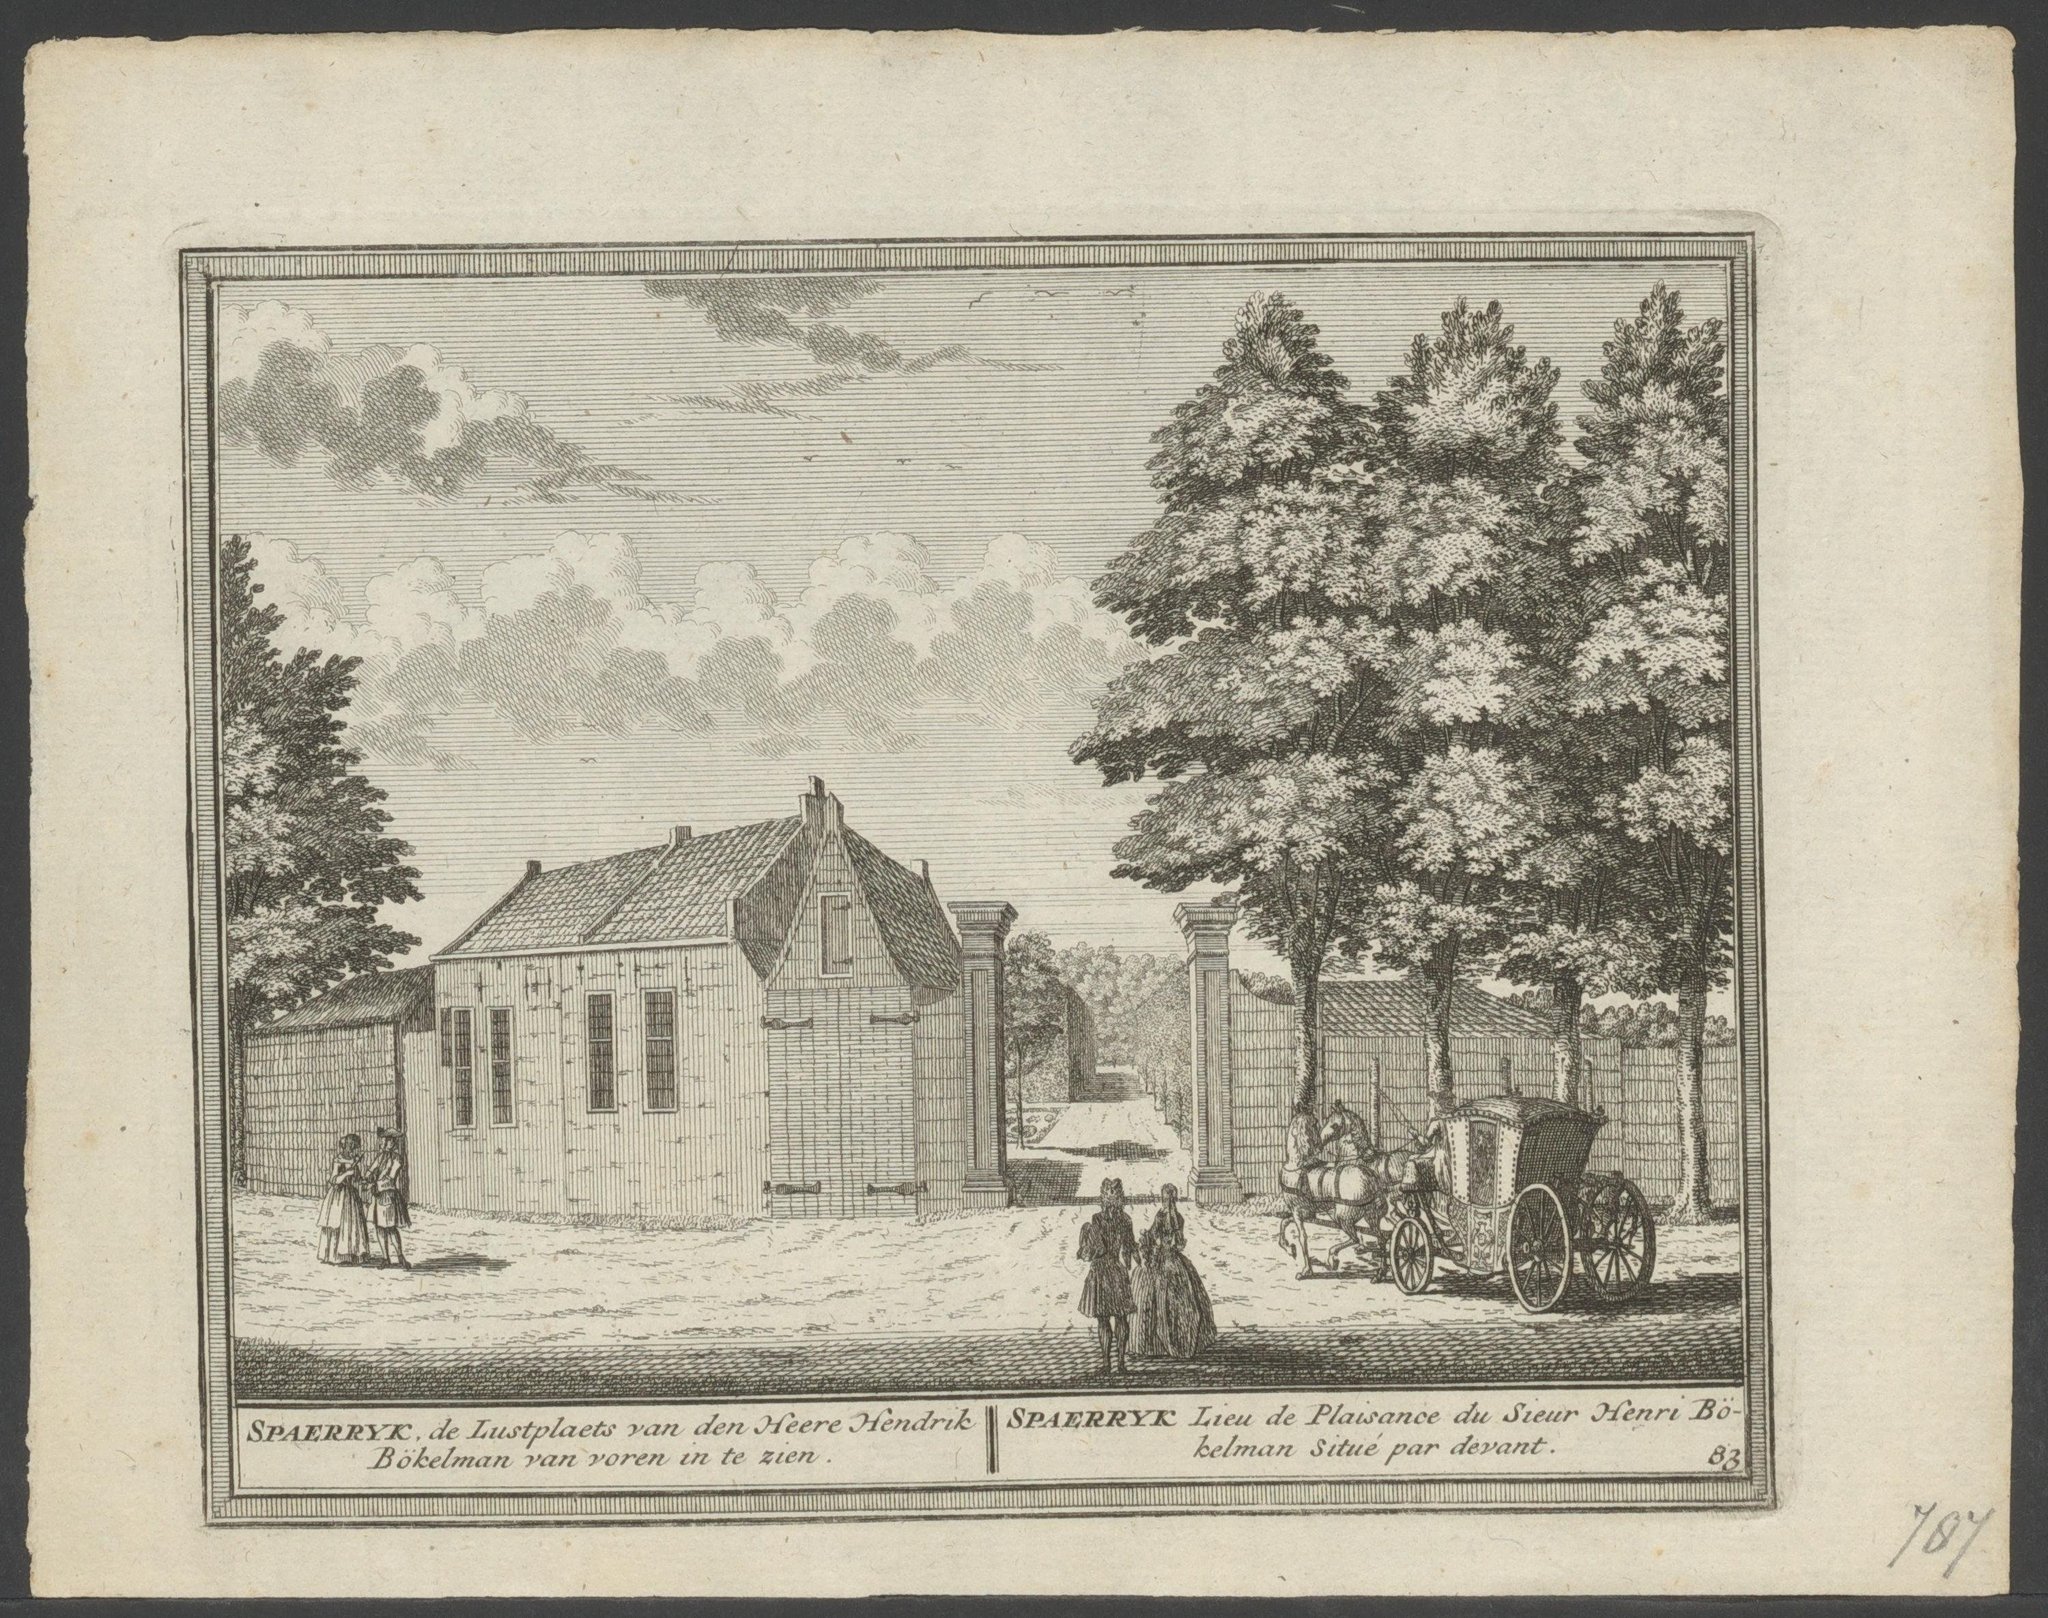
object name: print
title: Spaerryk, de Lustplaets van den Heere Hendrik Bökelman van voren in te zien / Spaerryk Lieu de Plaisance du Sieur Henri Bökelman Situé par devant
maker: hendrik de leth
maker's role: draughtsman, print maker, publisher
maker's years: 1703-1766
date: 1729-1732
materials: paper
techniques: engraving, etching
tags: rural housing, e.g. country-house, villa, cottage, haarlem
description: Prent mogelijk uit: Nidek, Matthaeus Brouërius. Het zegenpralent Kennemerlant, vertoont in veele heerelyke gezichten van deszelfs voornaemste lustplaetzen, adelyke huizen, dorp- en stede-gebouwen (...). Amsterdam: Andries en Hendrik de Leth, 1729-1732.